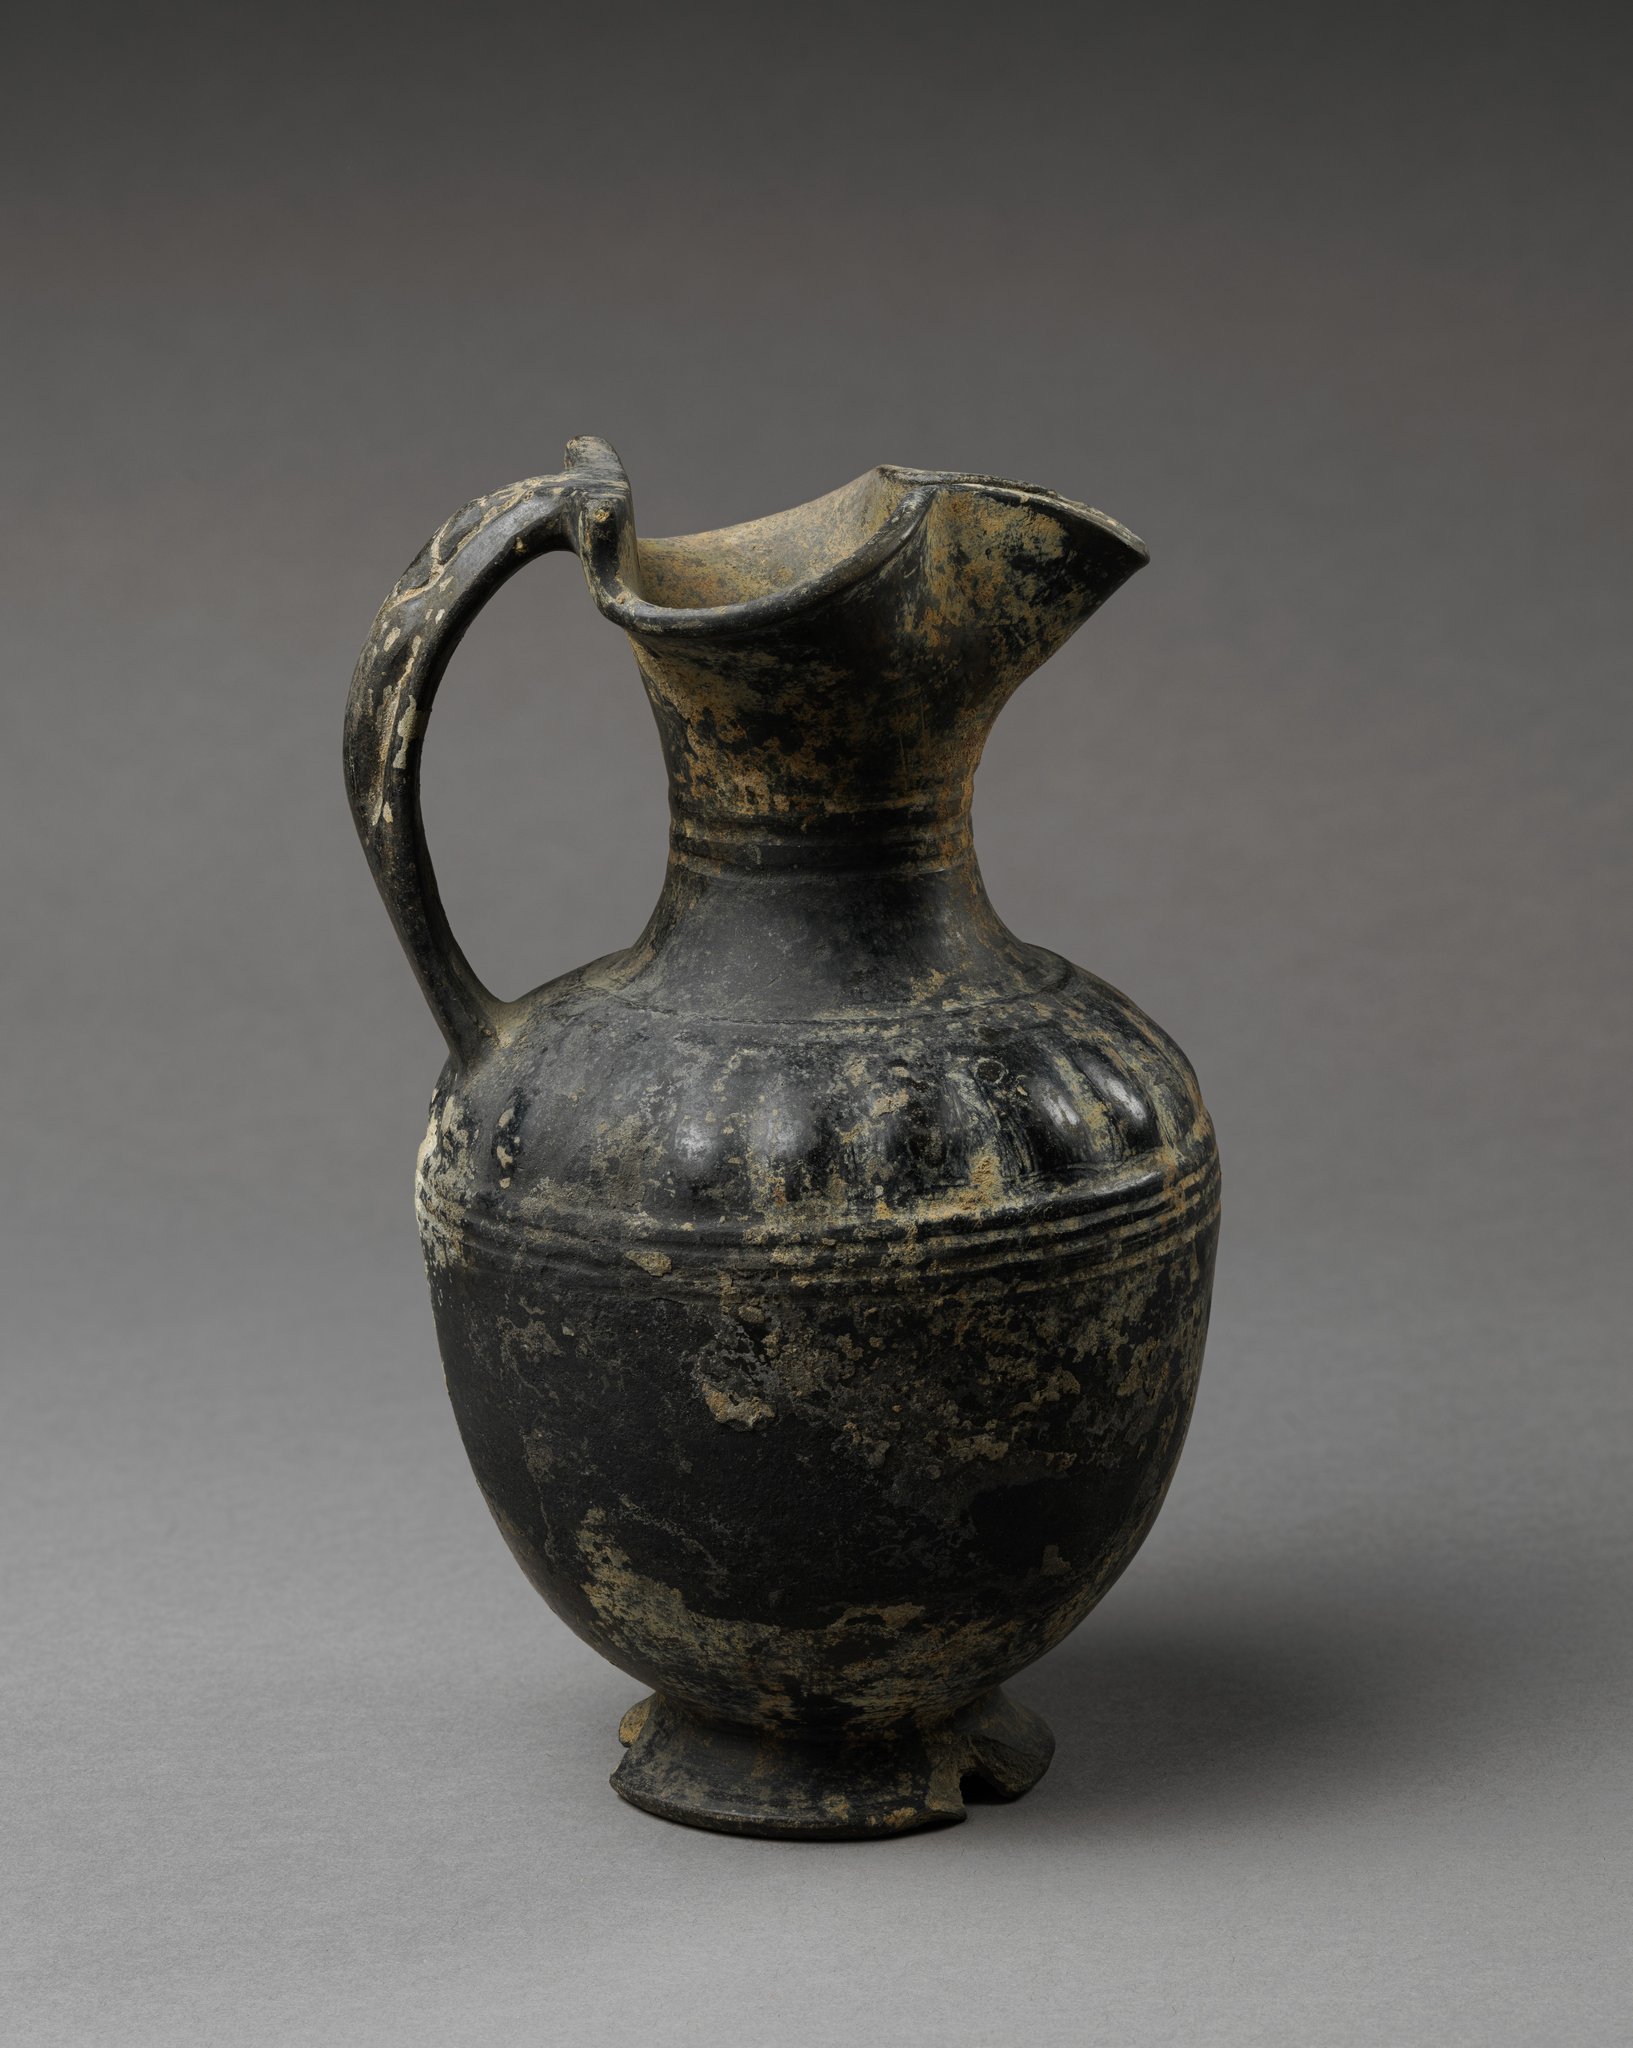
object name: jug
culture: etruscan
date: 600-301 BCE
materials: terracotta